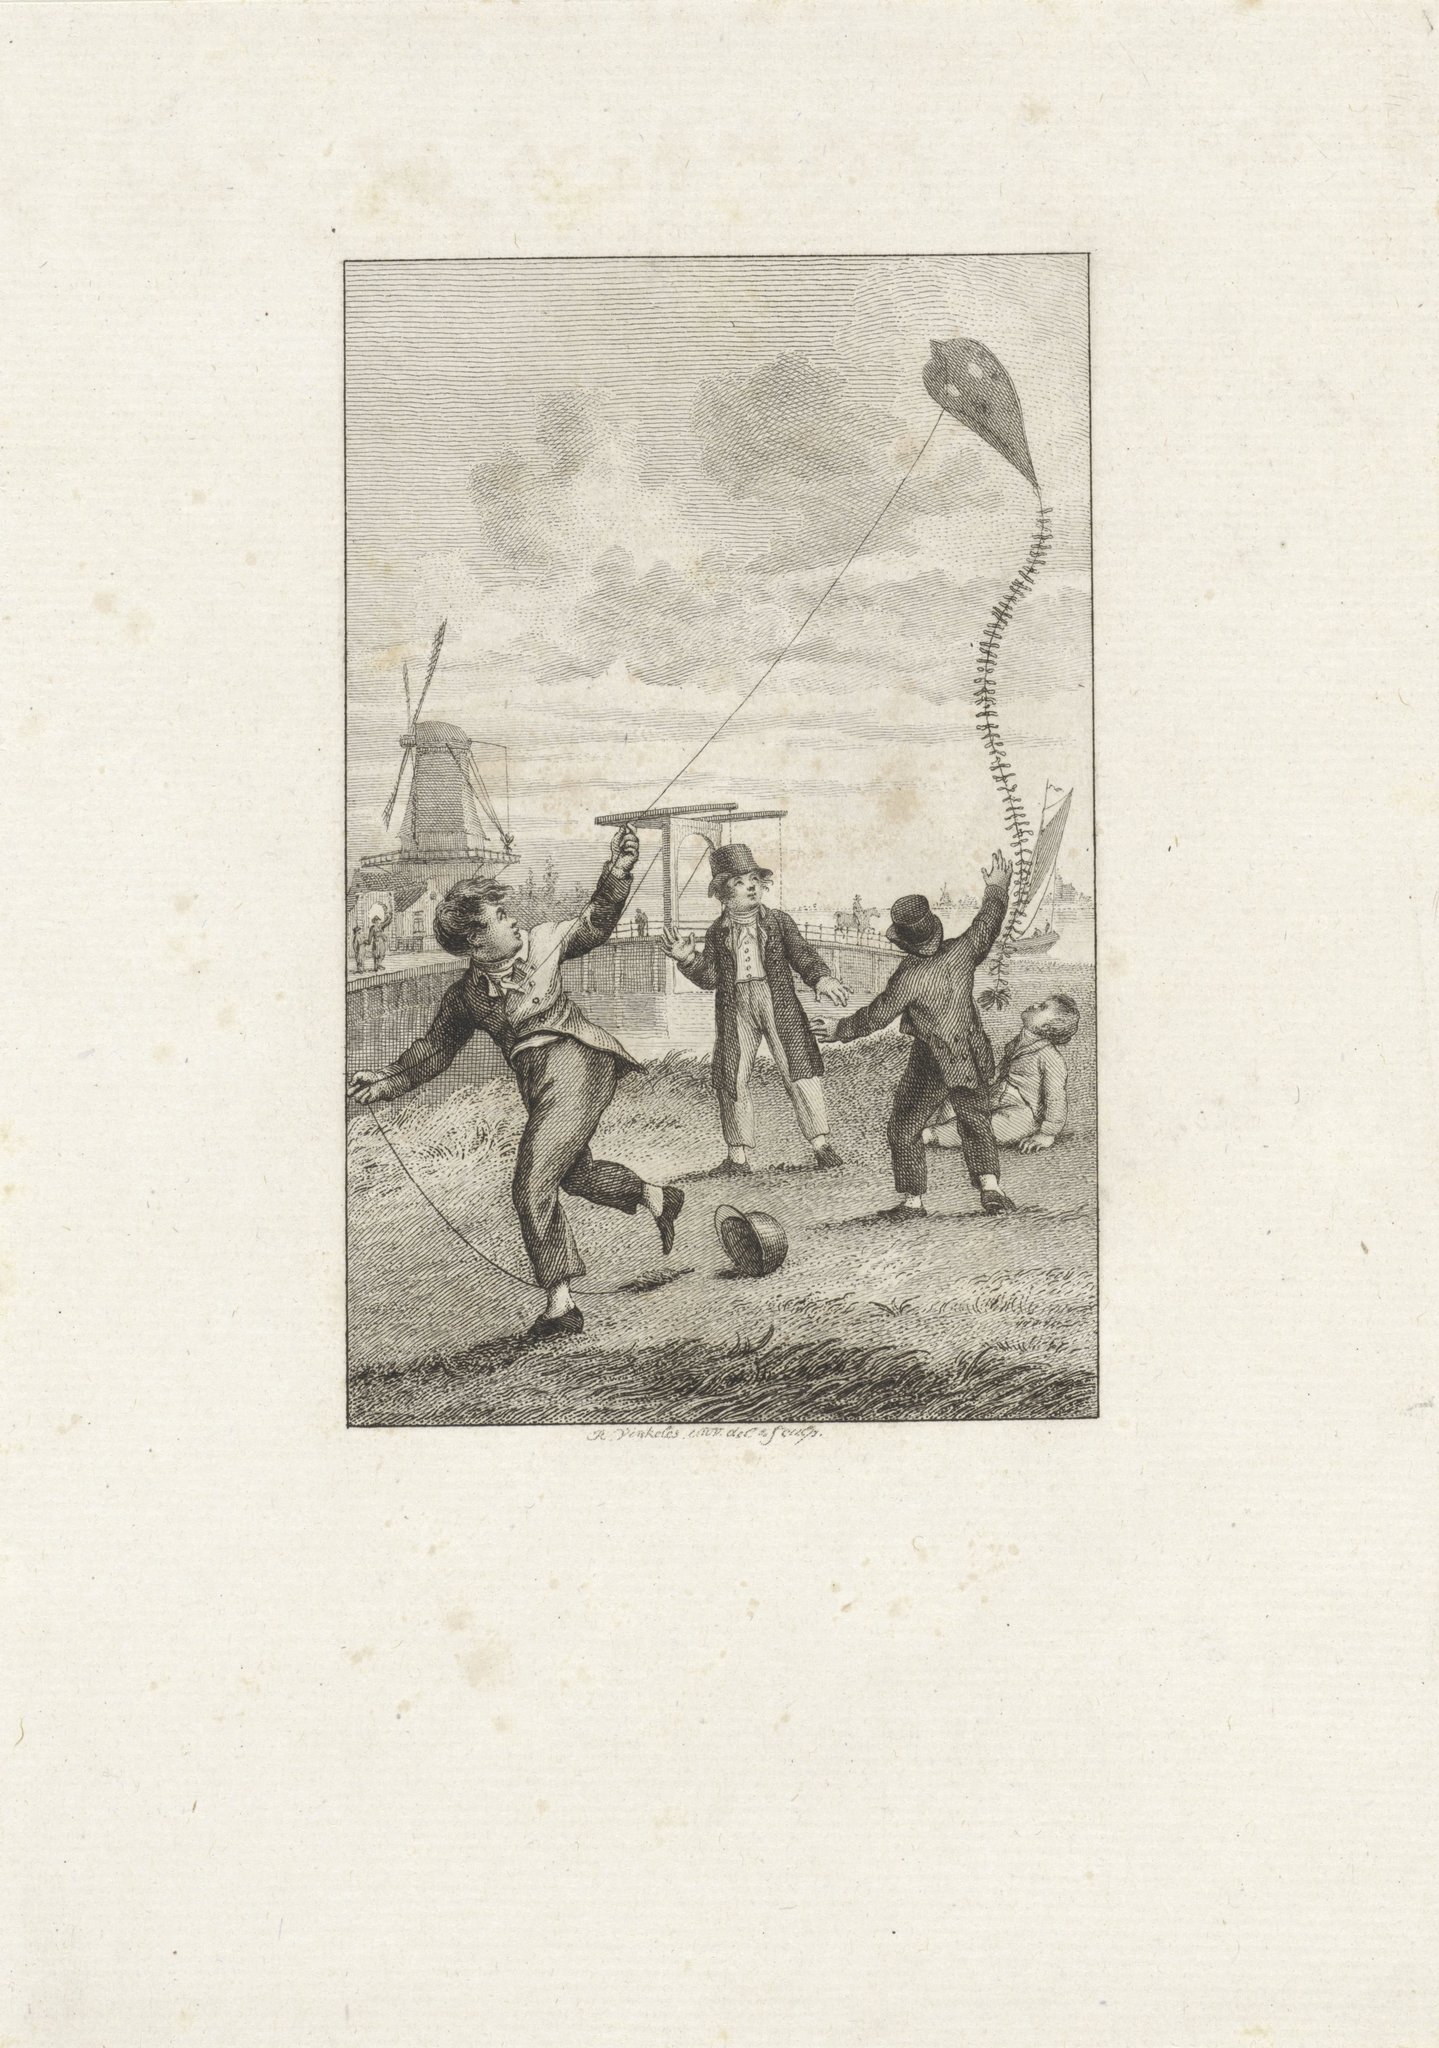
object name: print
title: Vliegerende jongen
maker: reinier vinkeles (i)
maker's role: draughtsman, print maker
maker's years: 1741-1816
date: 1809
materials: paper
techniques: engraving, etching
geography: amsterdam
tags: the ages of man, youth, adolescent, windmill in landscape, (flying a) kite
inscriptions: collector's mark: Lugt 2228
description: Enkele jongens kijken toe hoe een jongen een vlieger in de lucht laat zweven. Op de achtergrond een molen en een rivier met boten. De prent is een illustratie voor een boek over de vier 'tijdperken' van de man, van het tijdperk 'de jongen'.